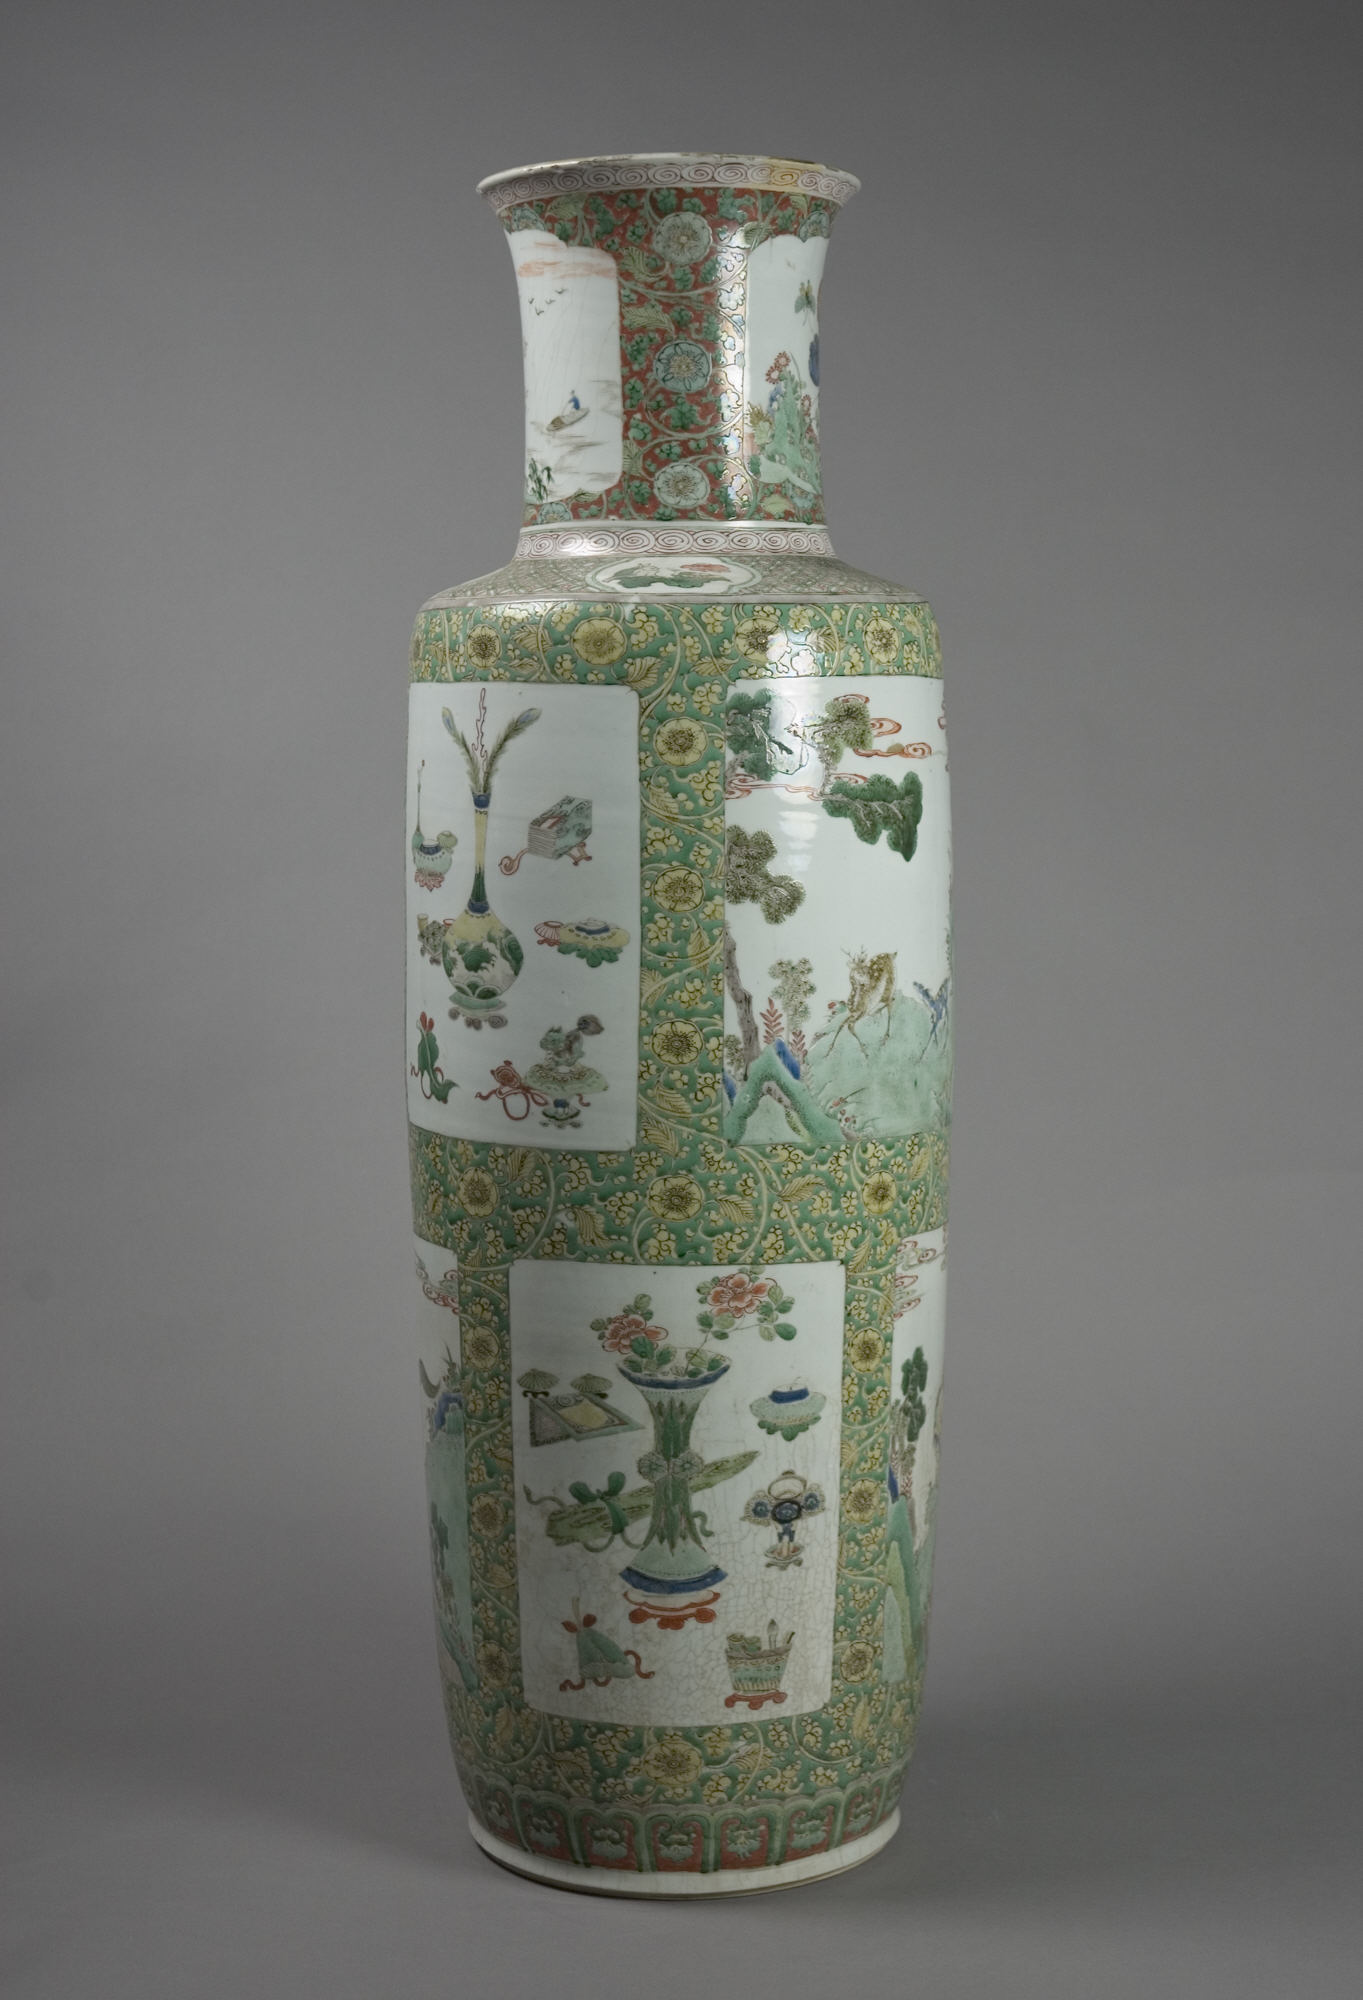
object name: vase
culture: chinese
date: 1662-1722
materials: porcelain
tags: flowers,leaves